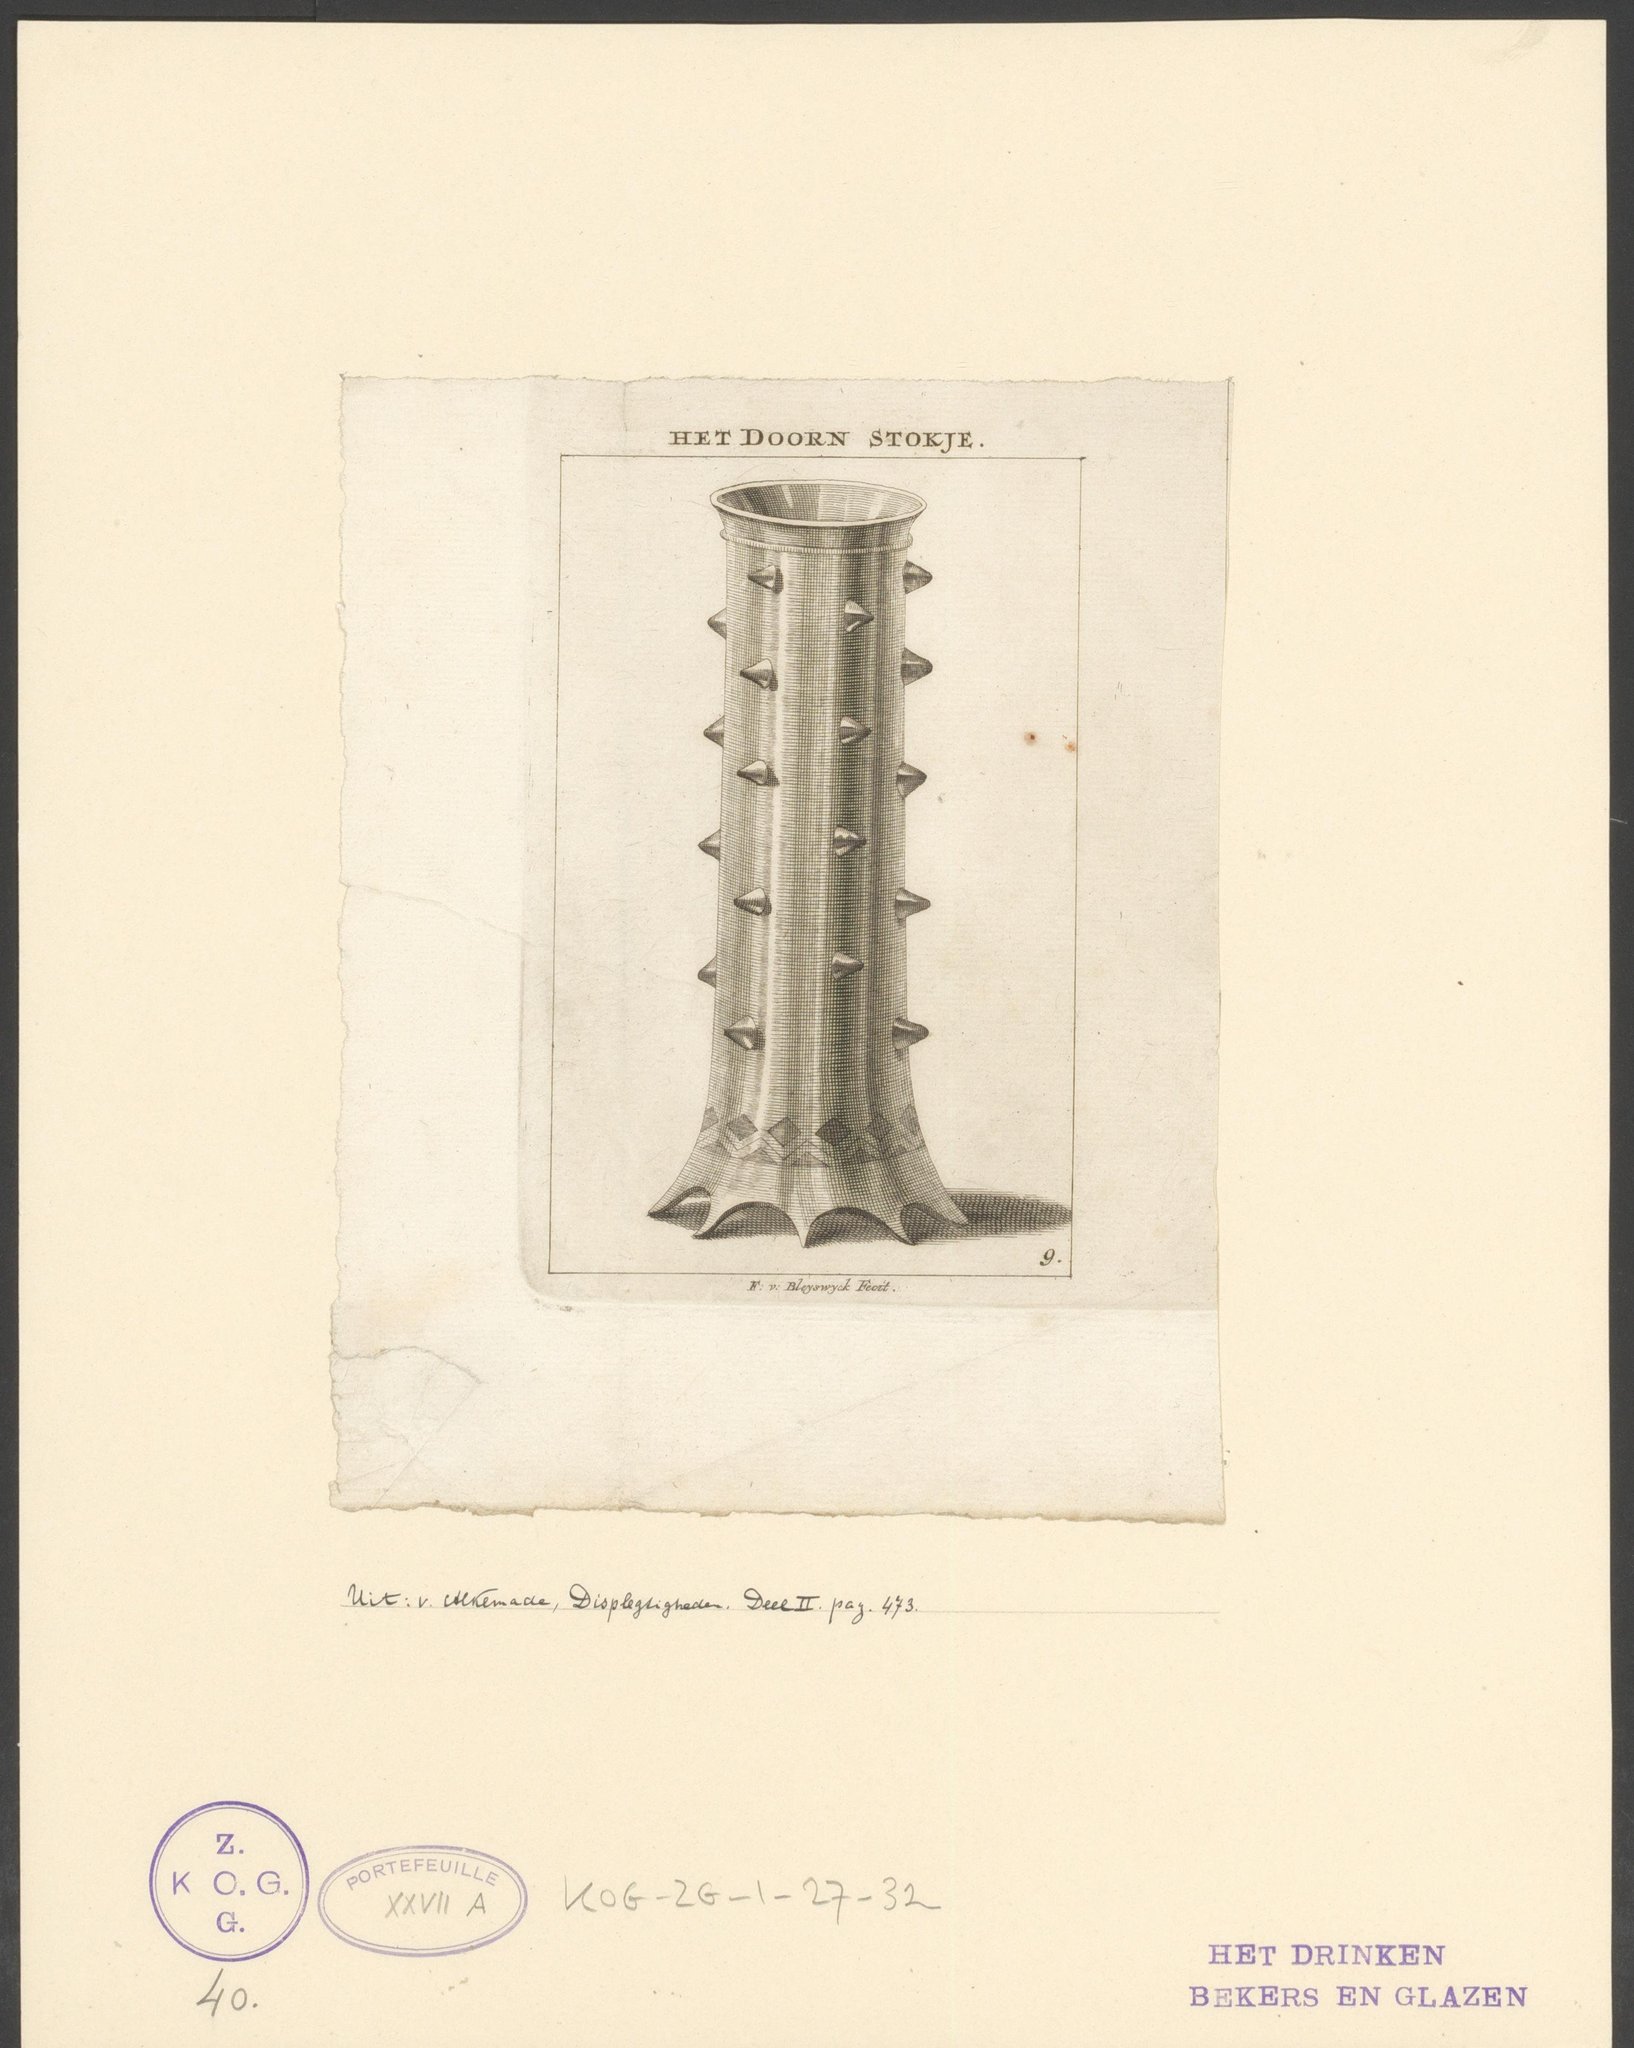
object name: print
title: Het Doorn stokje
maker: françois van bleyswijck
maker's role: draughtsman, print maker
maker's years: 1671-1746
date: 1732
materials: paper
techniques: etching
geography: netherlands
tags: glass, rummer, alcoholic drinks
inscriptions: collector's mark: Lugt 1641, collector's mark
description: Gebruikt als illustratie in: Cornelis van Alkemade en Pieter van der Schelling, Nederlands displegtigheden. Rotterdam: Philippus Losel, 3 dln. 1732-1735, dl. II (1732), t.o. p. 473.